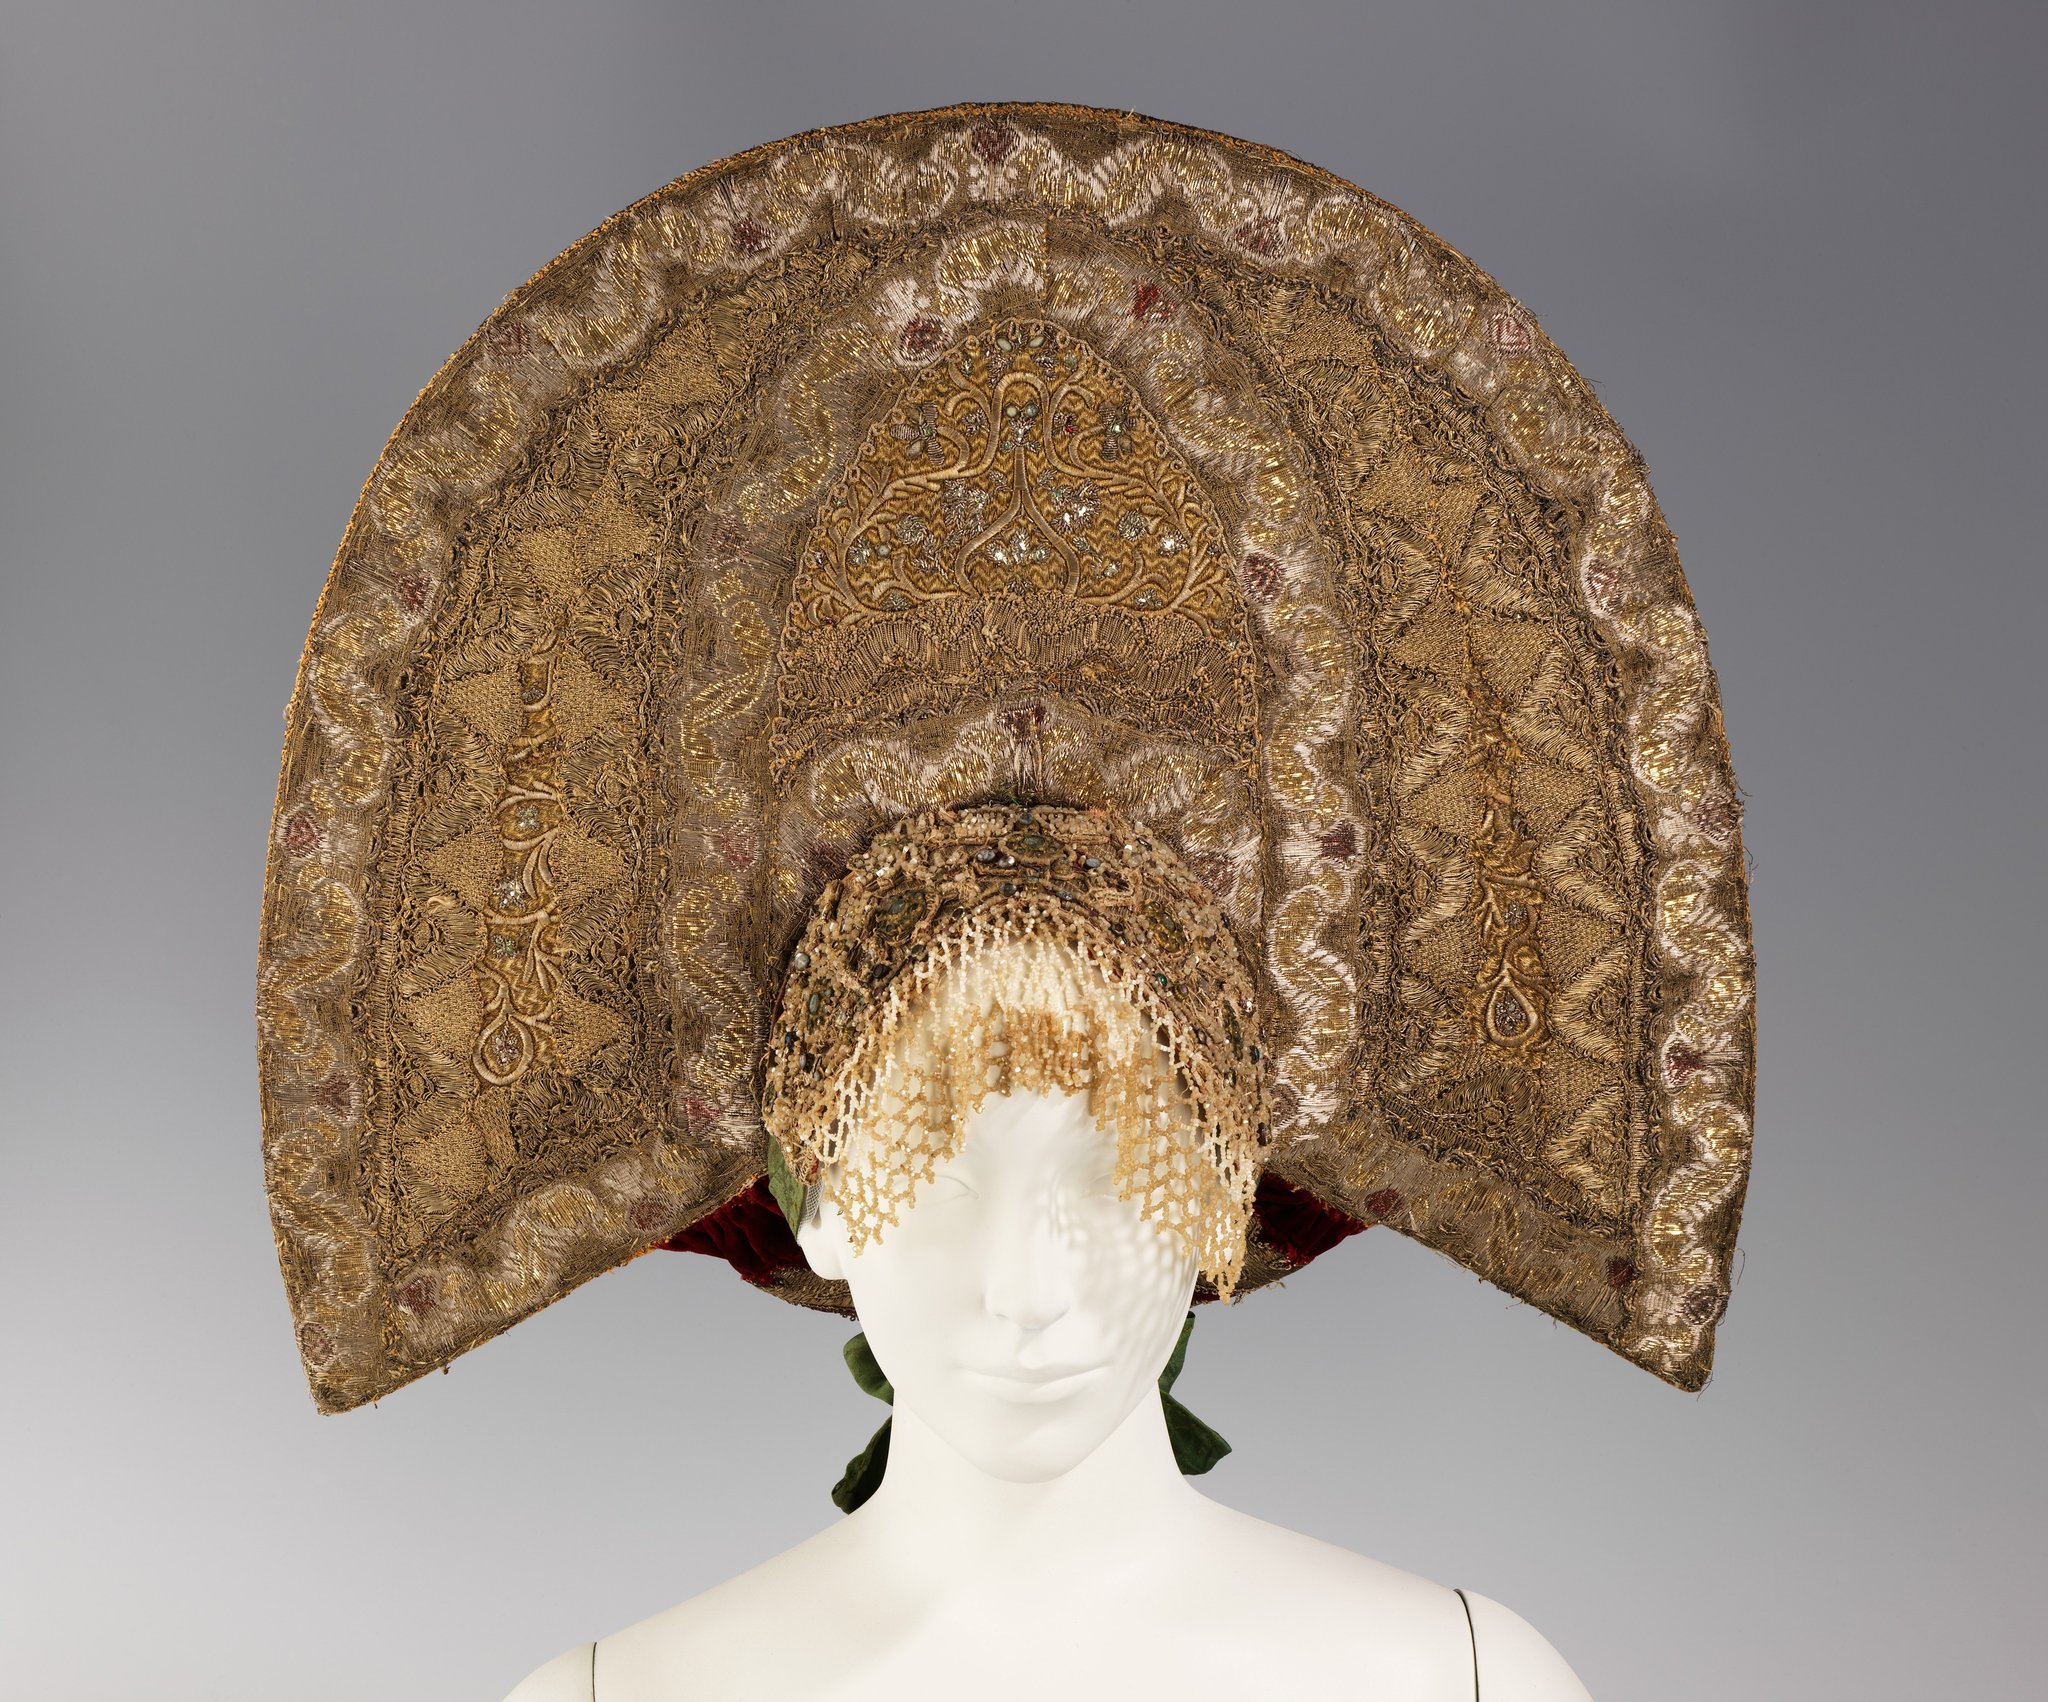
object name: headdress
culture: russian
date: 1800-1880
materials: cotton, glass, metal, mother of pearl, paper, silk, stone